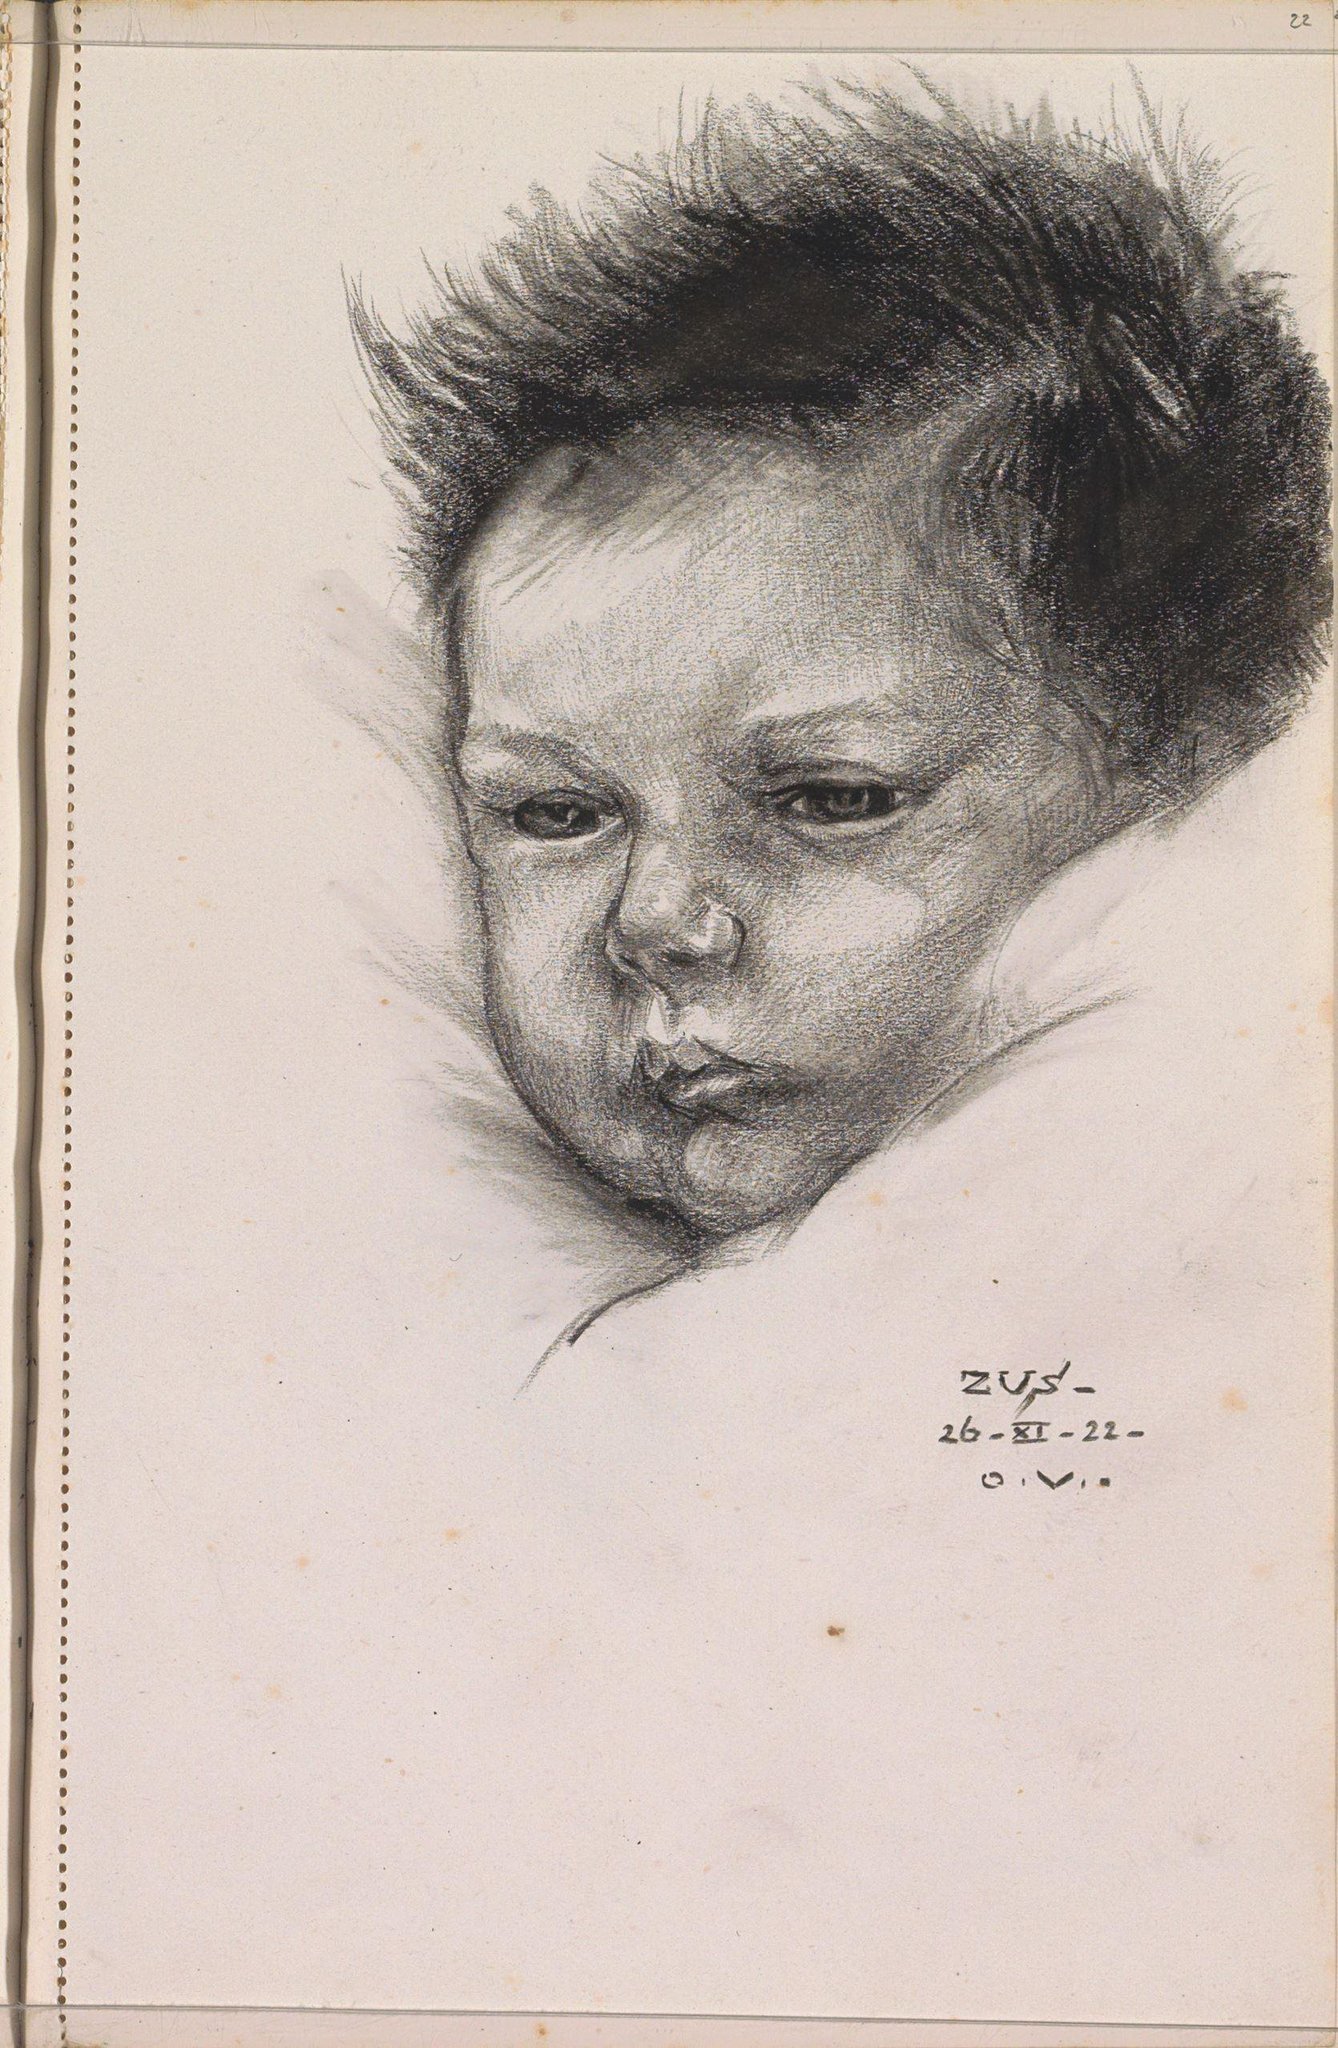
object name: sketchbook leaf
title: Portret van Zus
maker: otto verhagen (i)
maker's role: draughtsman, print maker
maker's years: 1885-1951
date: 1911-1922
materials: chalk, paper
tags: head (human), infant, baby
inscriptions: date and inscription: ‘ZUS/ 26-XI-22-/ O.V.’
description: Het kind ligt met de ogen open op een kussen. Pagina 22 uit een schetsboek met 34 bladen.